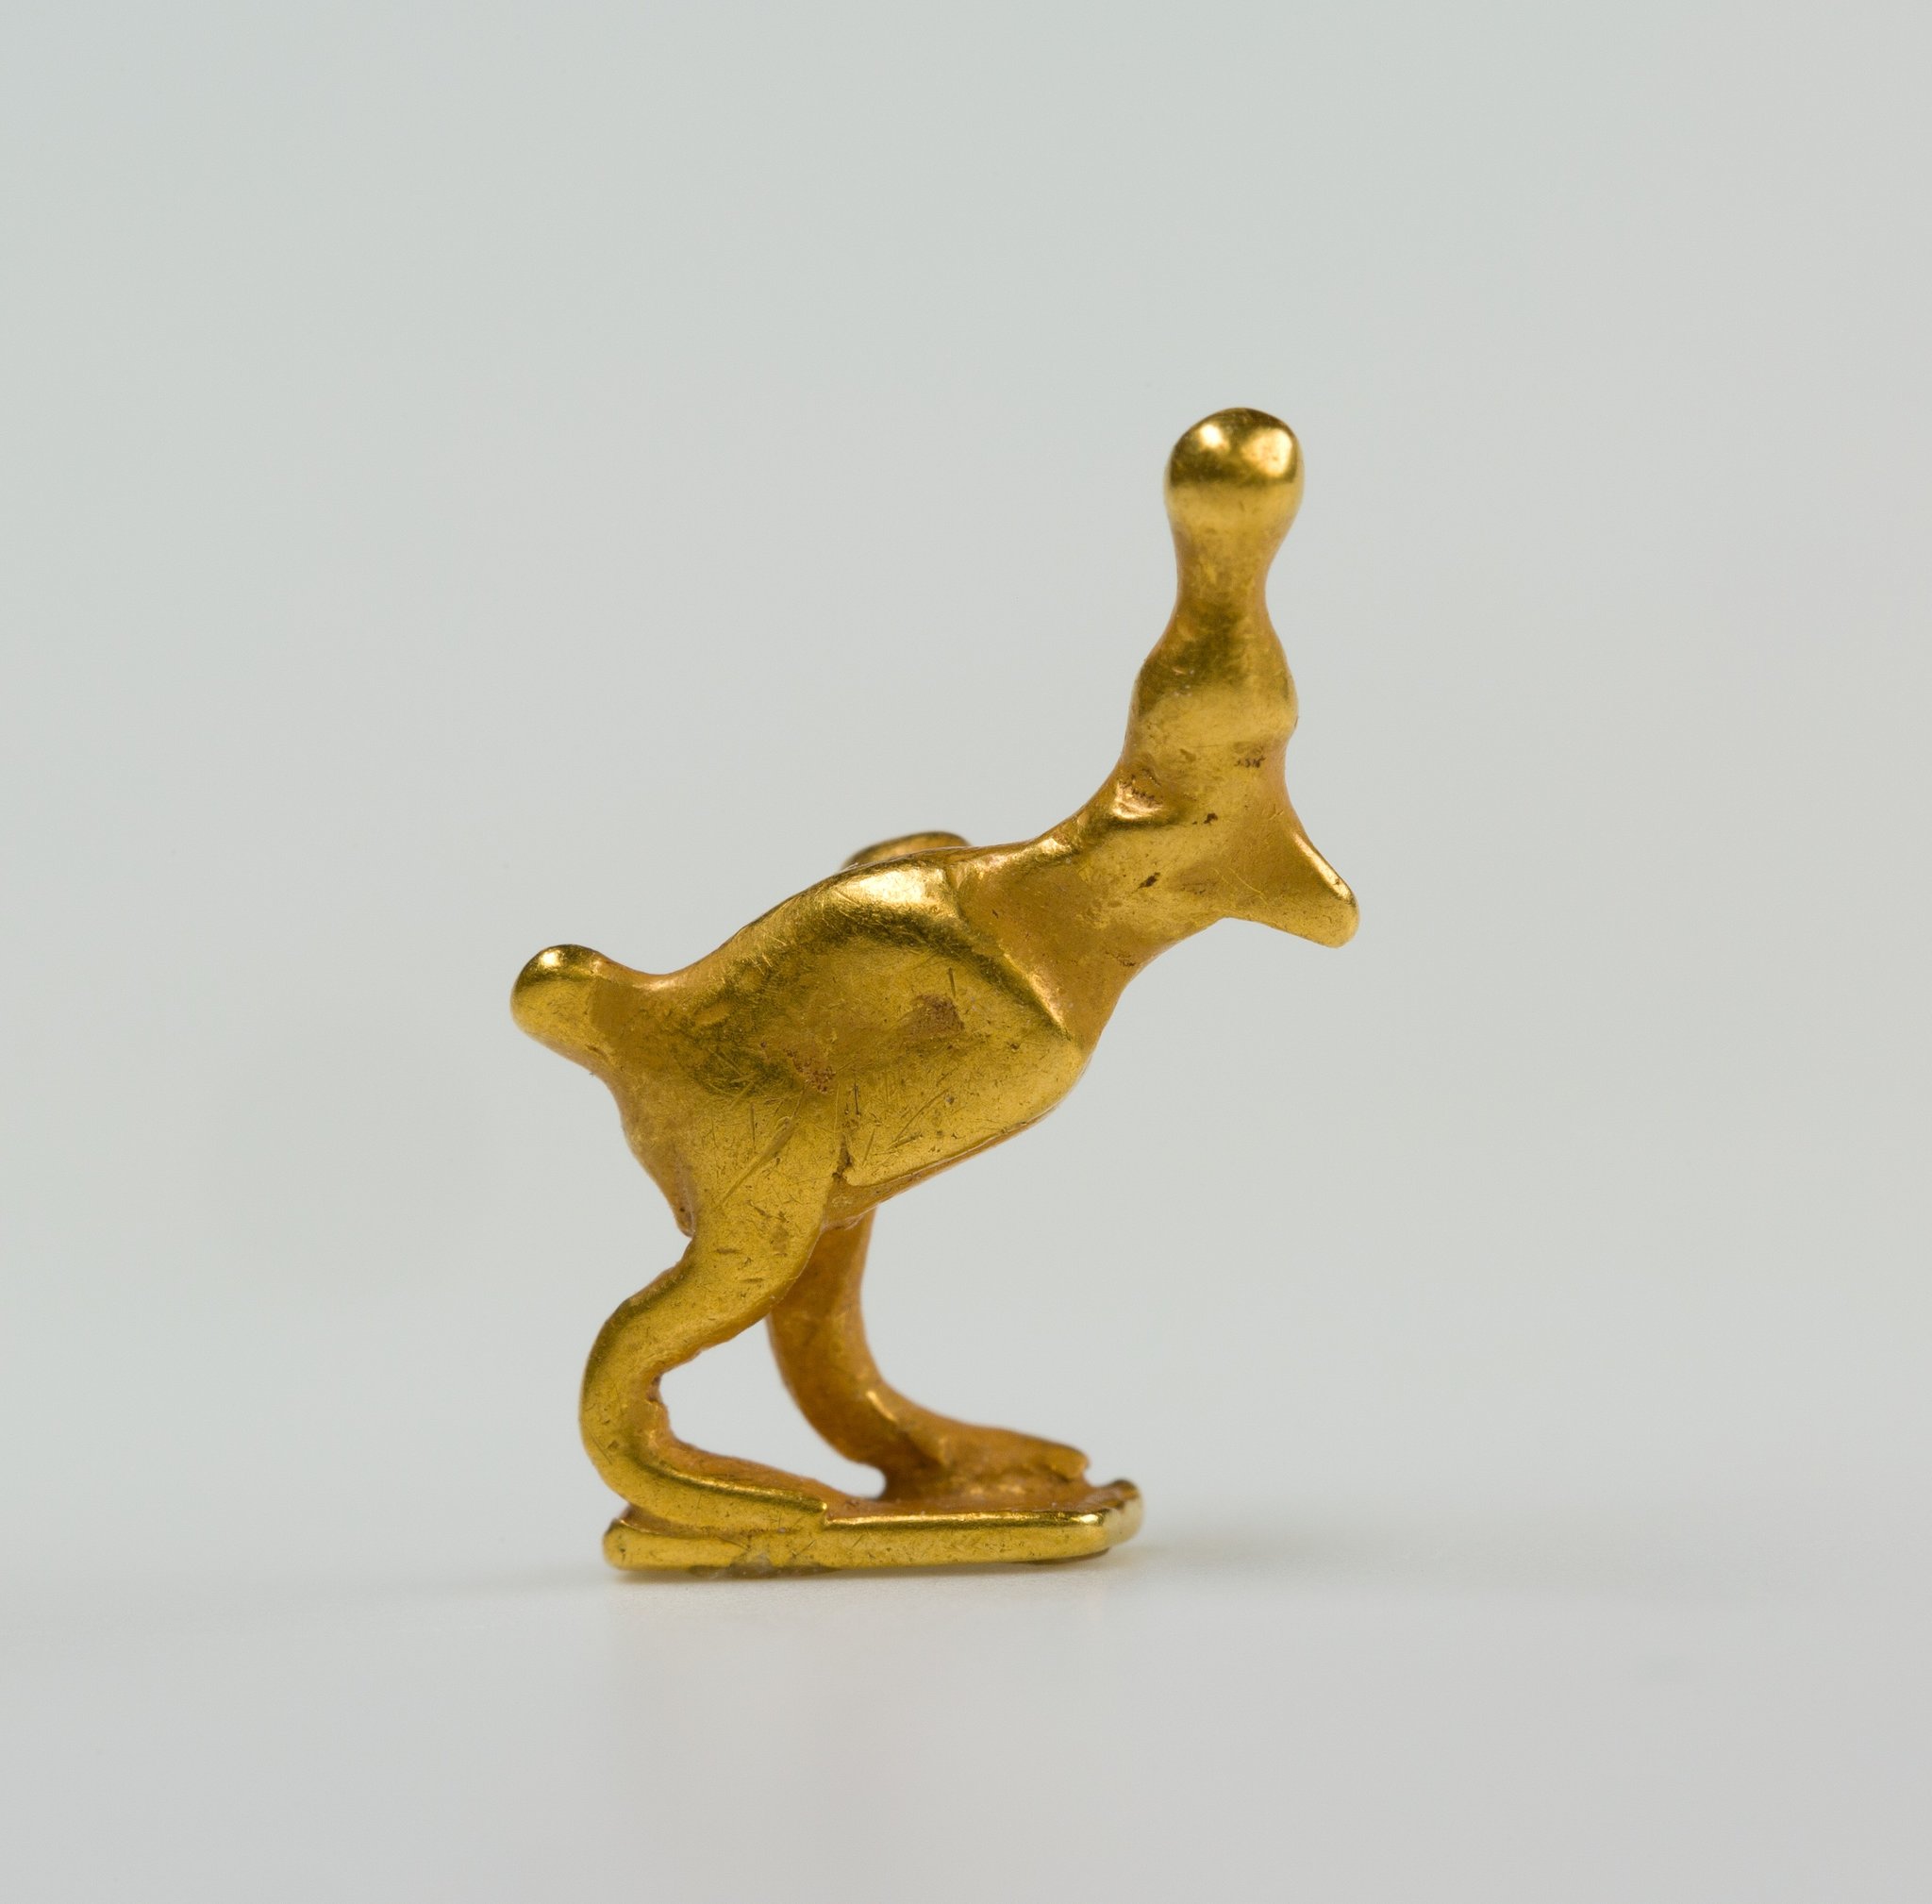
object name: quail chick amulet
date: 1981-1550 BCE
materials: gold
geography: egypt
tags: birds